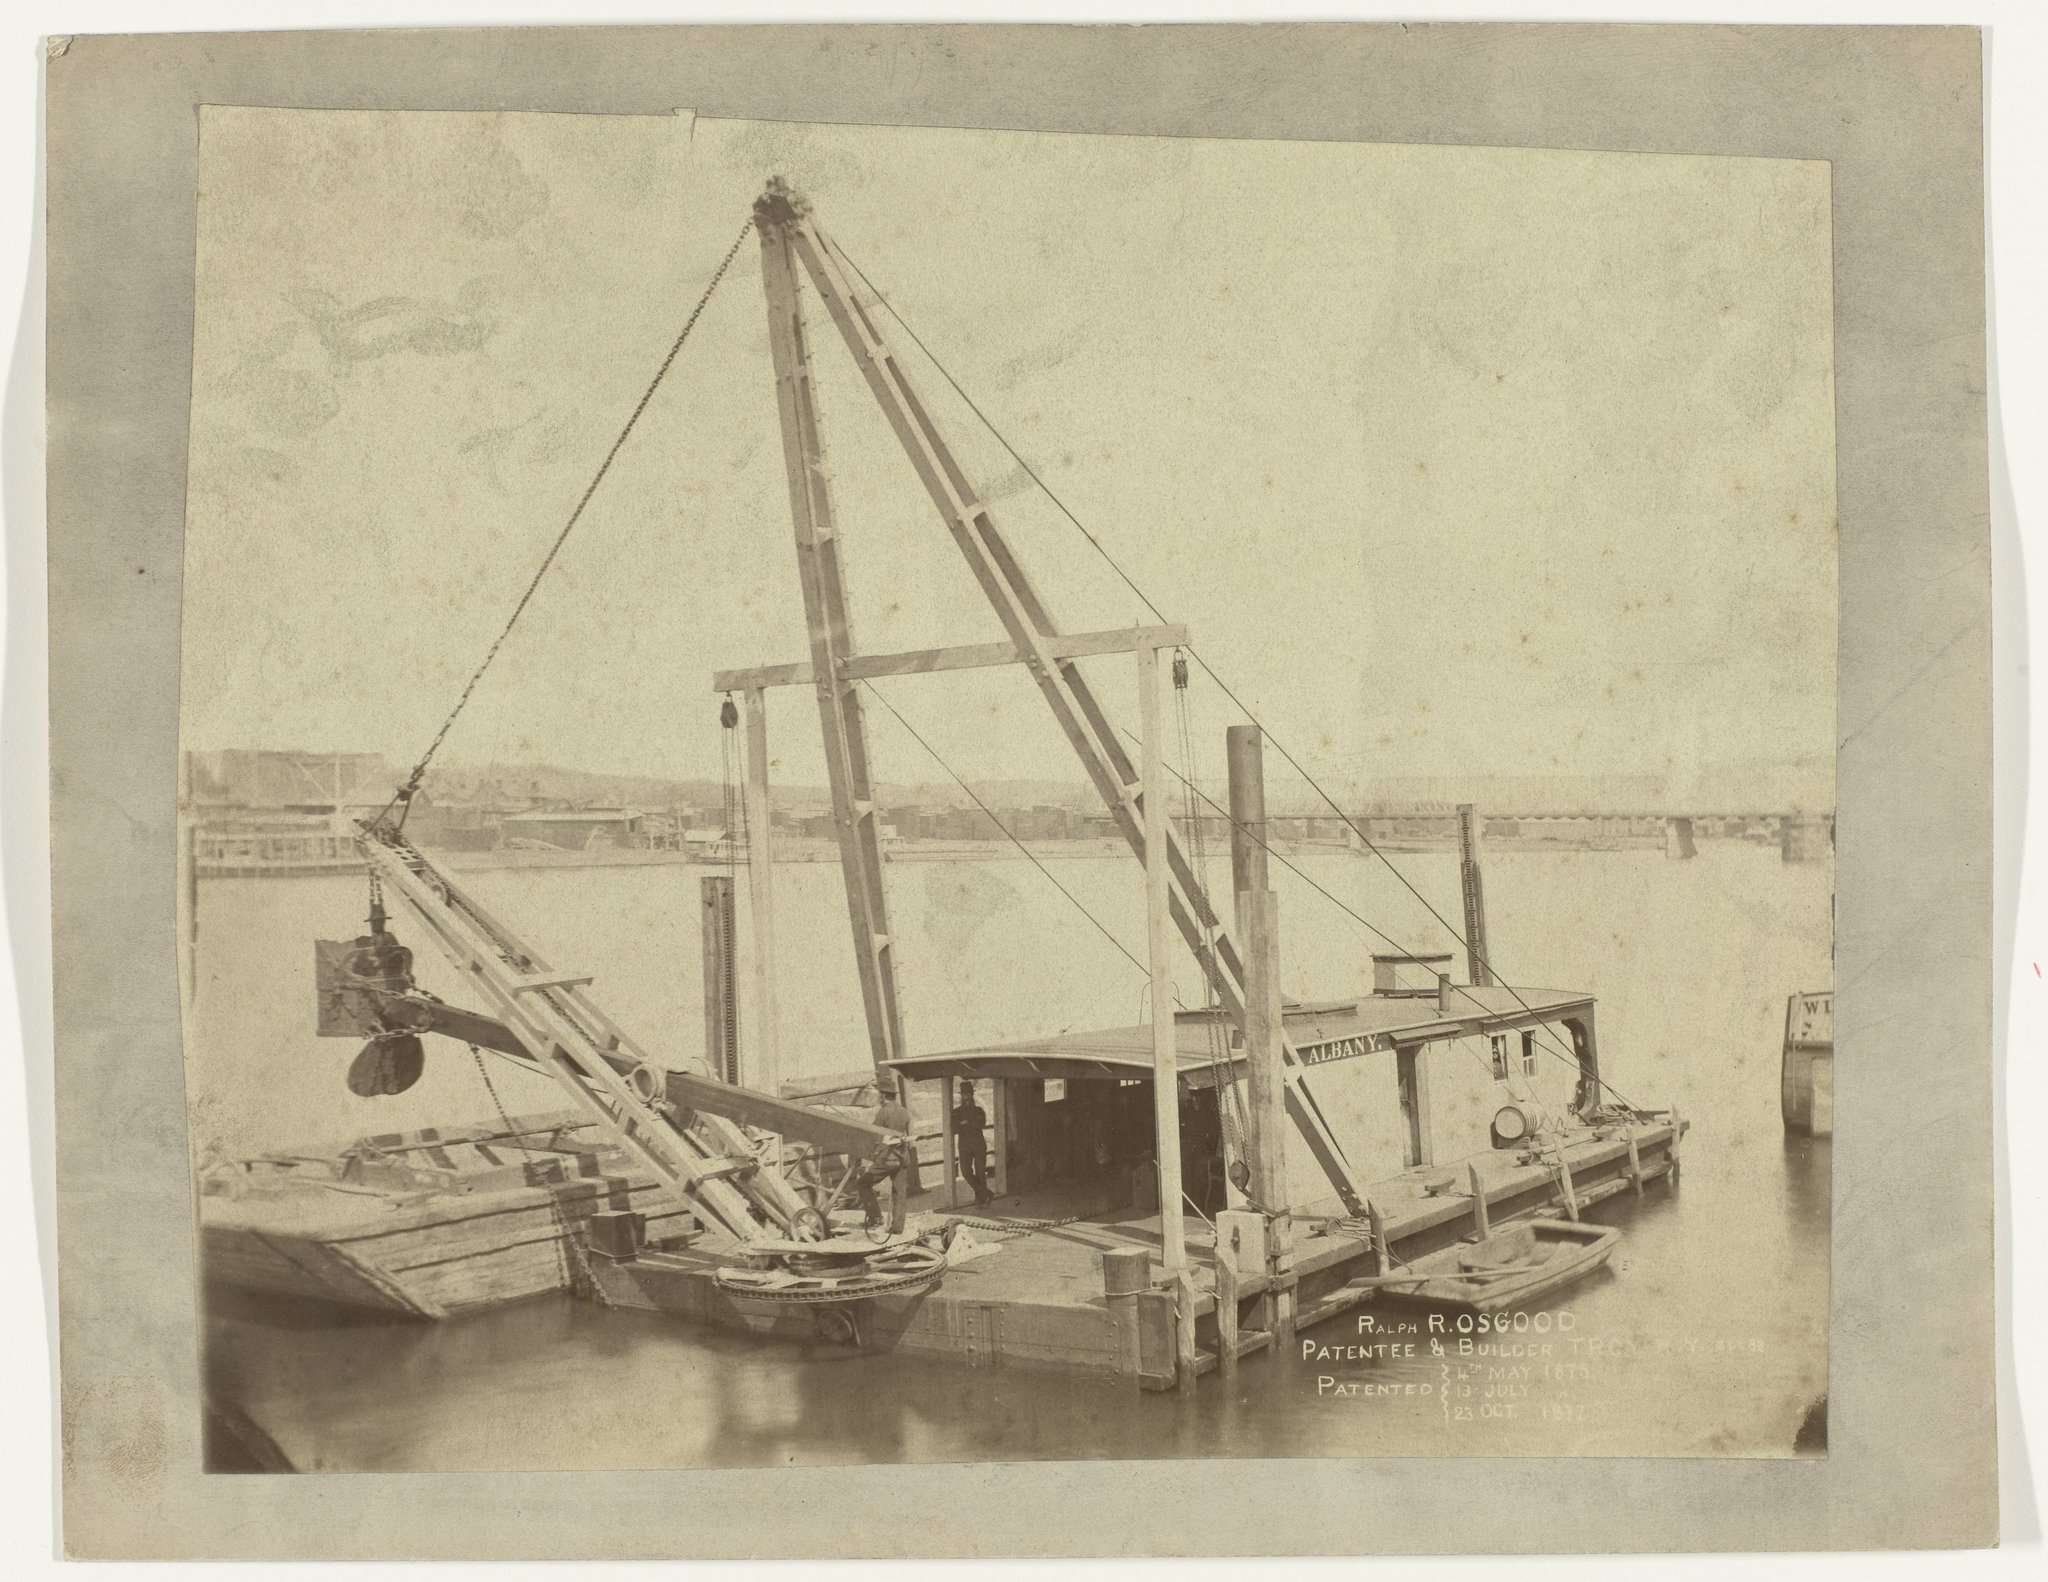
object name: photograph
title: Waterbouwkundig graafwerktuig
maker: Anonymous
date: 1875-1900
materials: cardboard, paper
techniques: photography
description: Foto op karton, van een waterbouwkundig werktuig (graafwerktuig). Opschrift: 'Ralph R. Osgood, patentee & builder Troy N.Y. Patenden (4th May 1875, 13 July, 23 Oct. 1877).